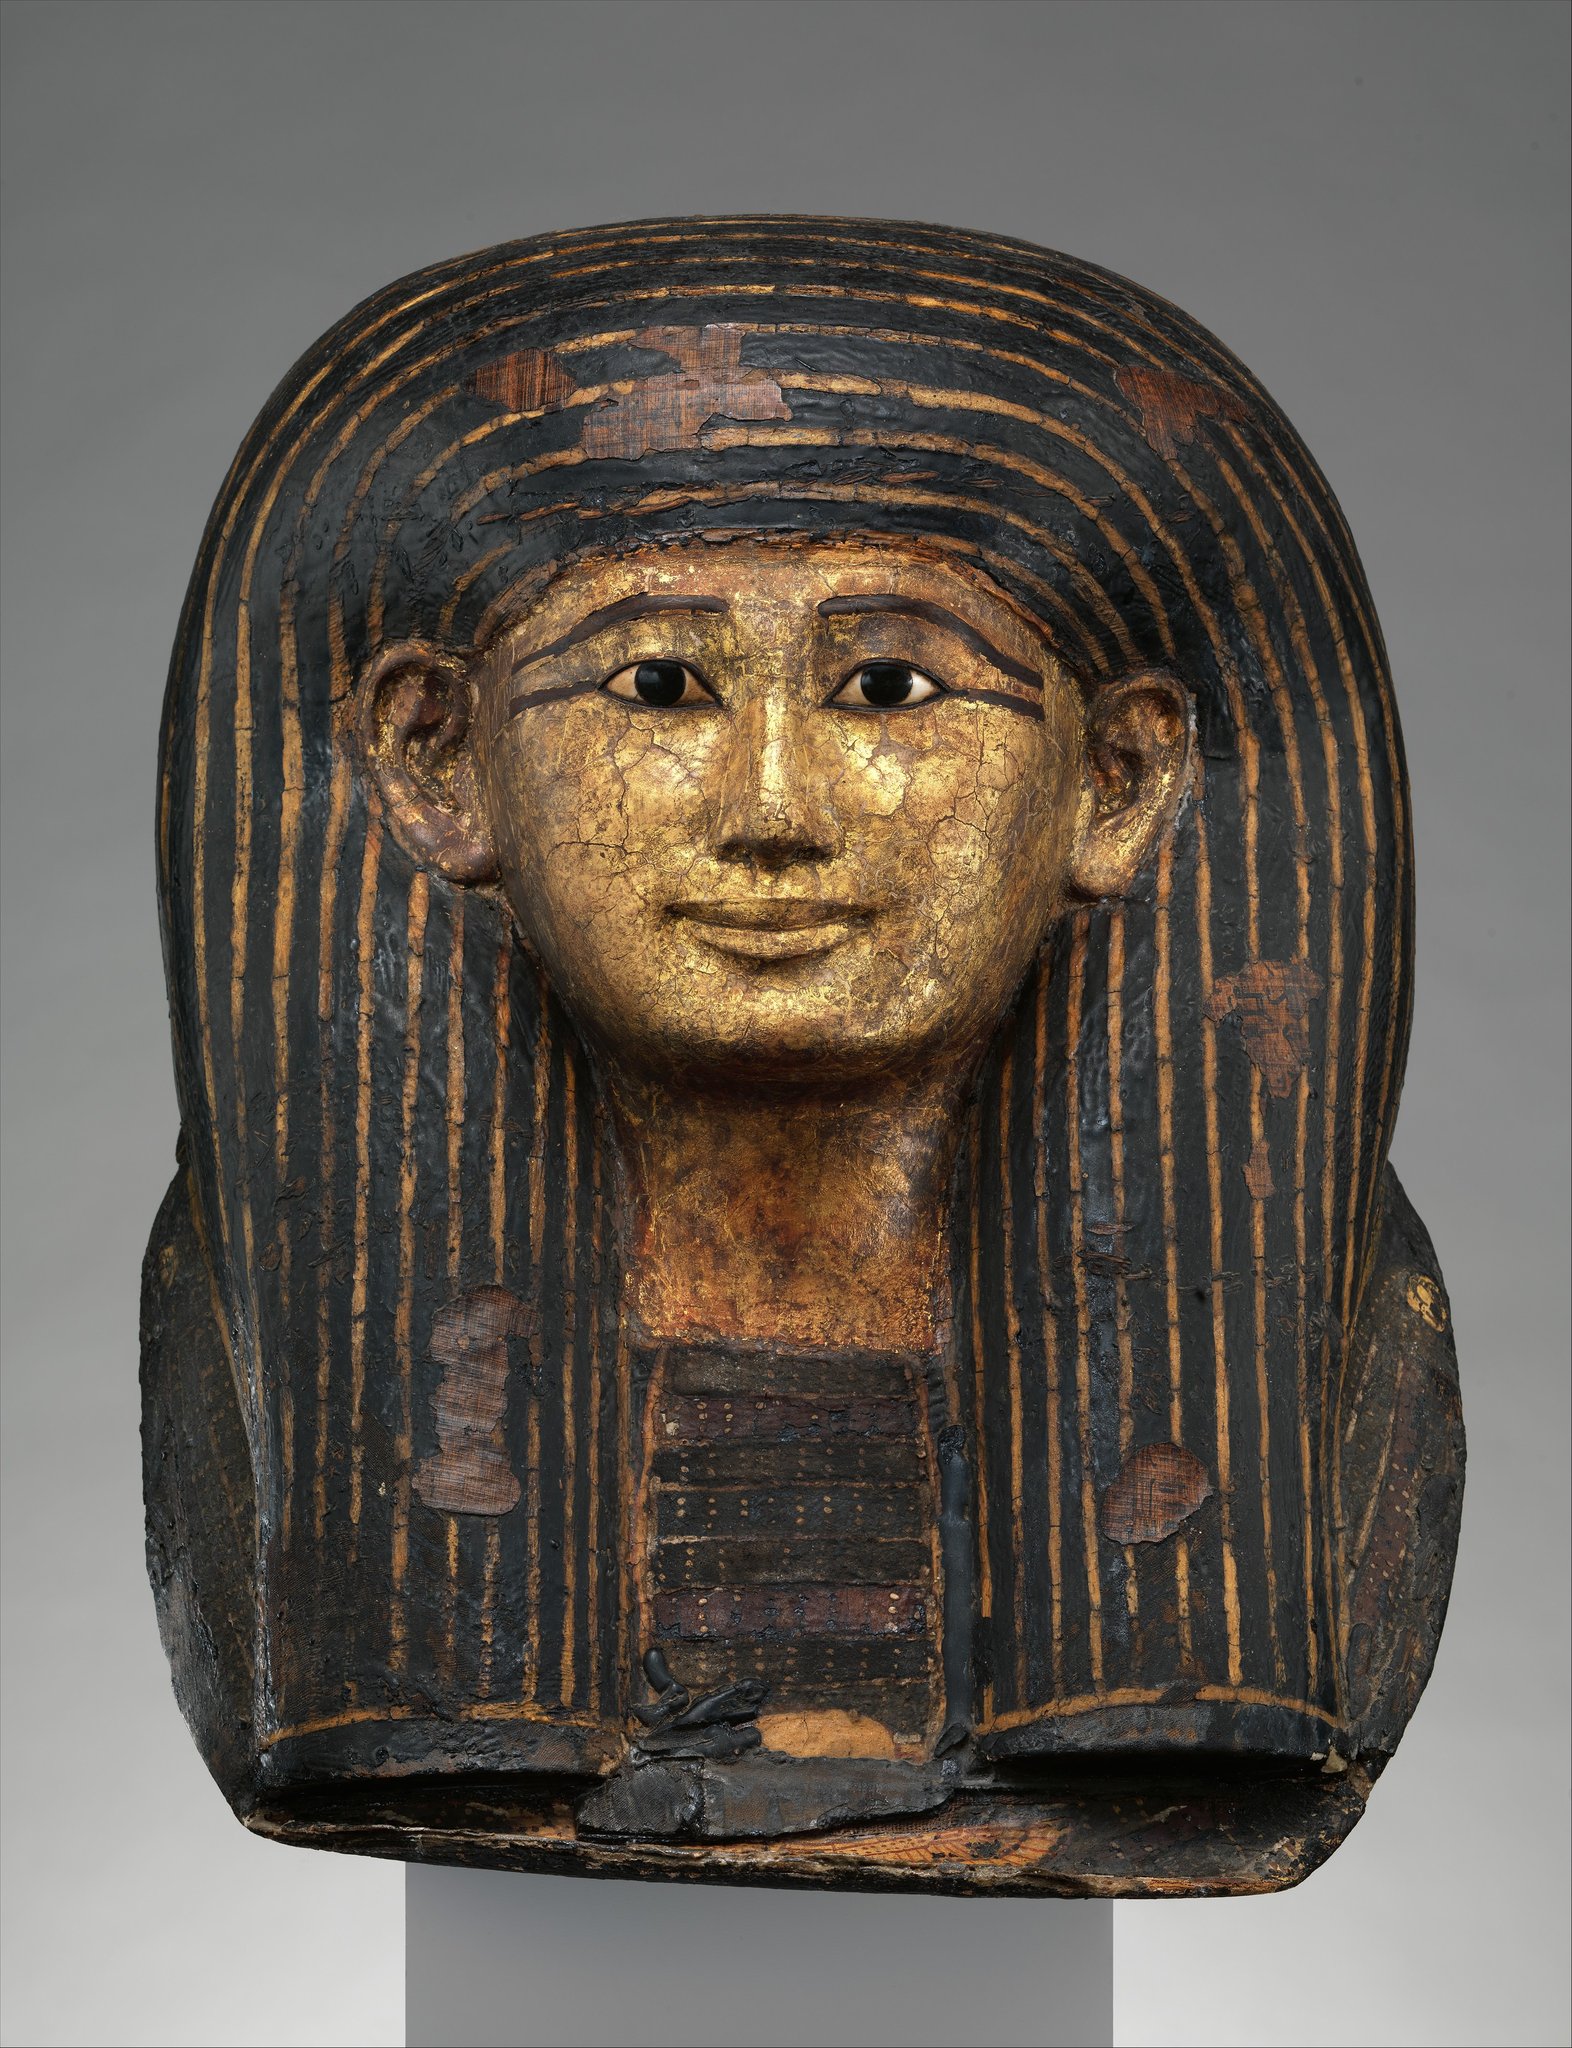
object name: mask, amenhotep, overseer of builder, tt a 7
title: Funerary Mask of the Overseeer of Builders Amenhotep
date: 1427-1390 BCE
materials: paint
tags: masks